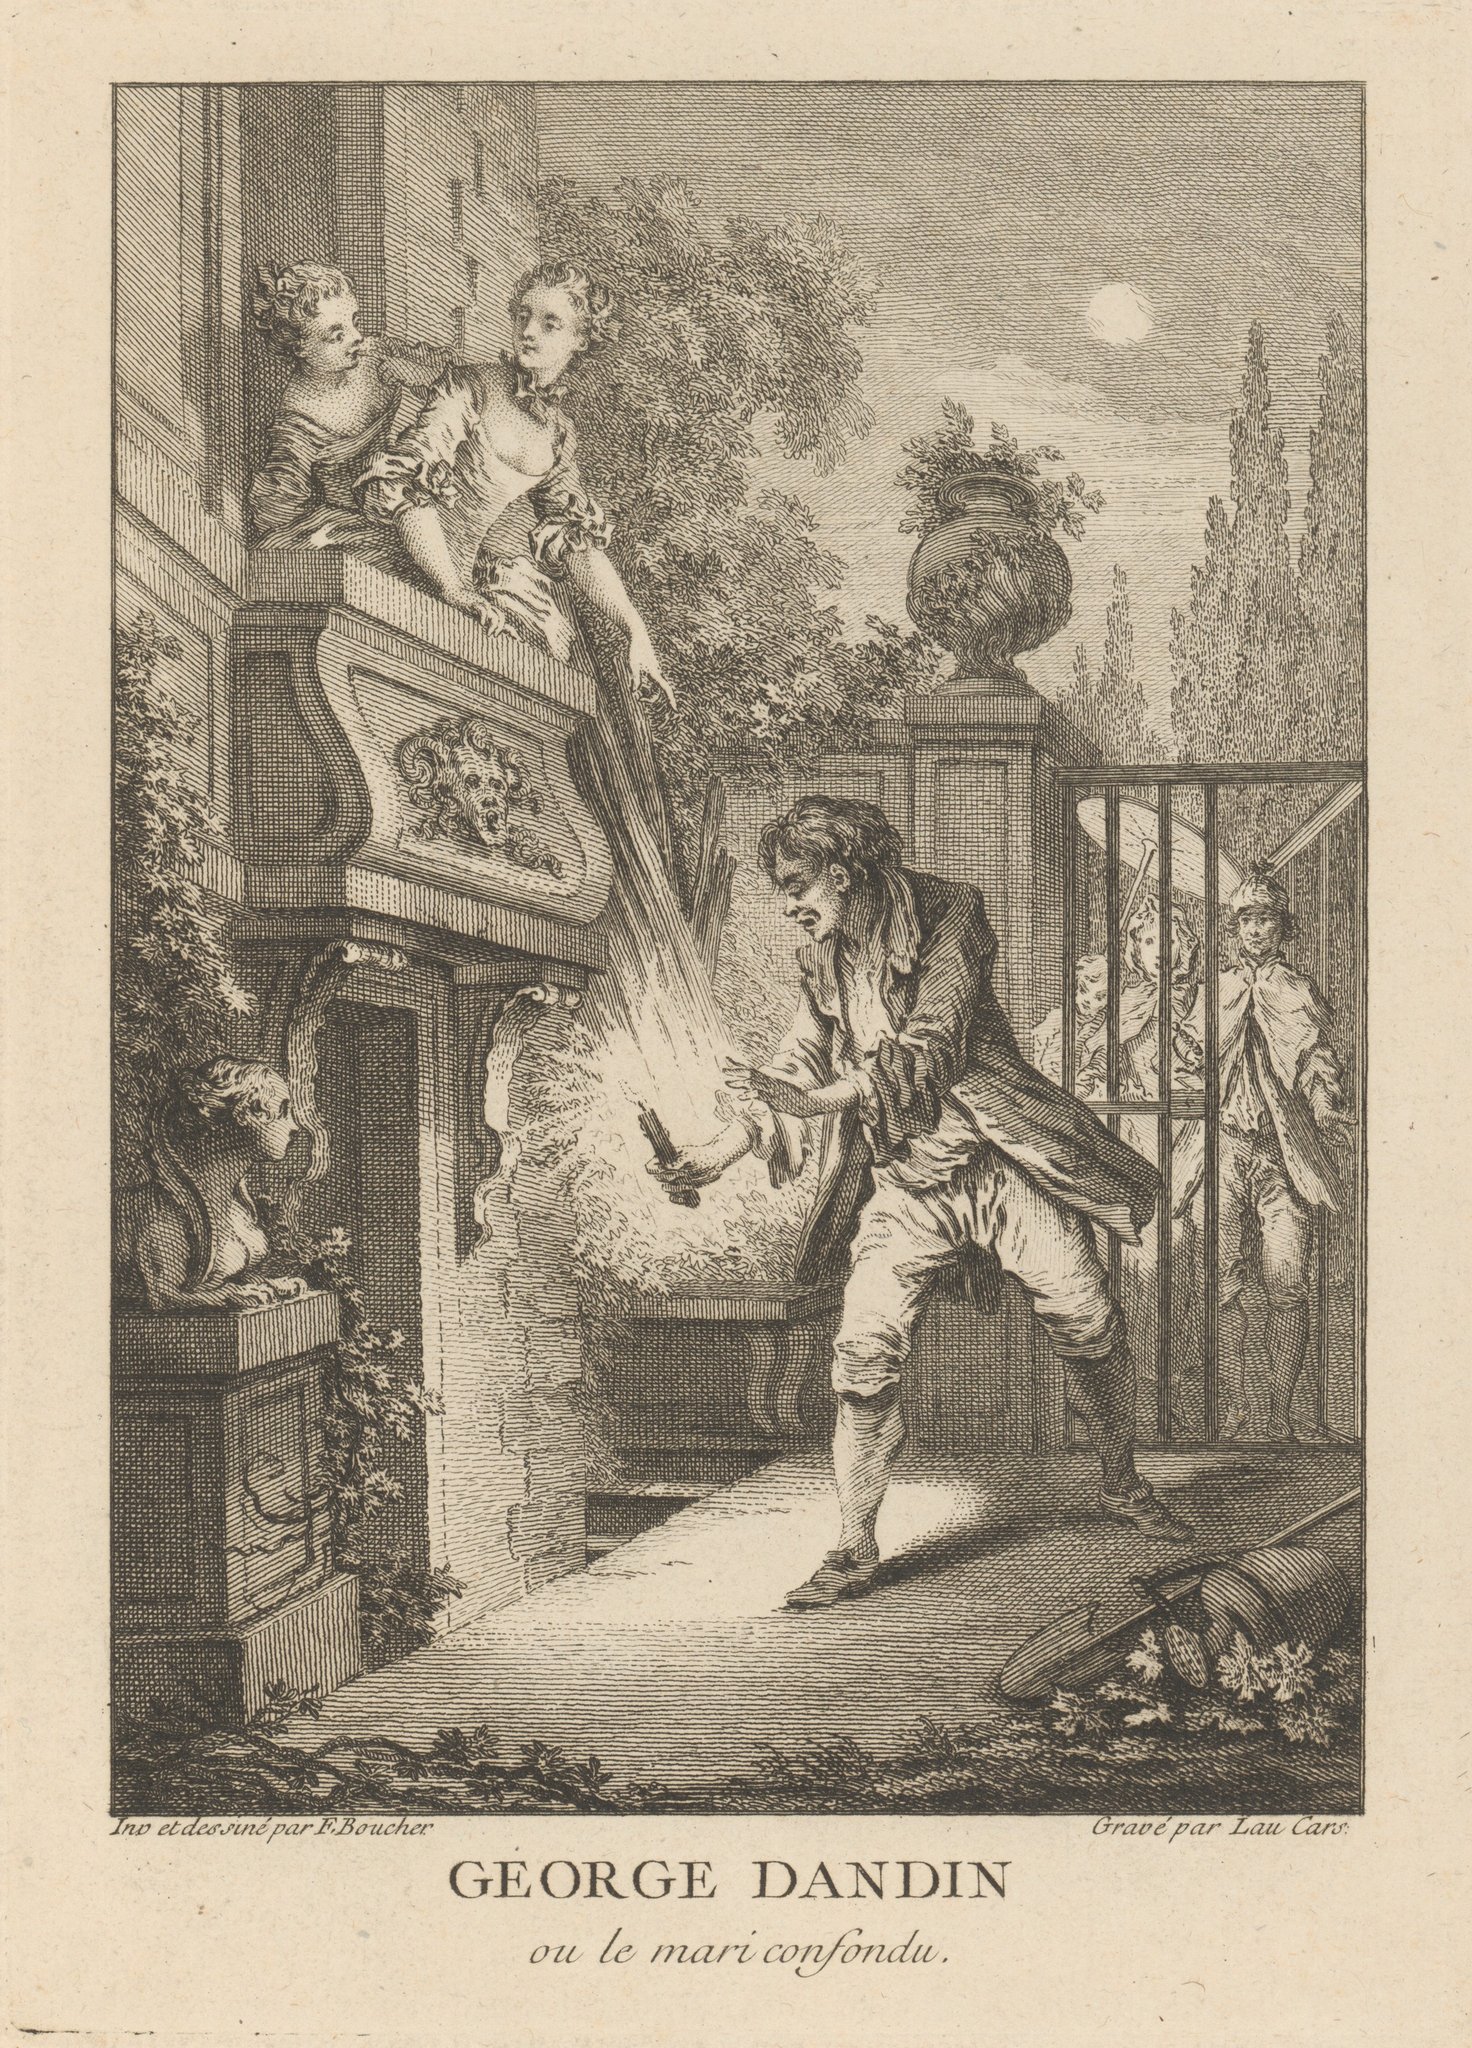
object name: book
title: Gravures de Boucher pour les Oeuvres de Molière [Figures de Boucher pour Molière]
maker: jean-baptiste mauzaisse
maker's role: artist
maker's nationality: french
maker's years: 1784-1844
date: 1734-1766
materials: graphite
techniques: engraving, etching, mezzotint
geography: france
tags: men,women,trees